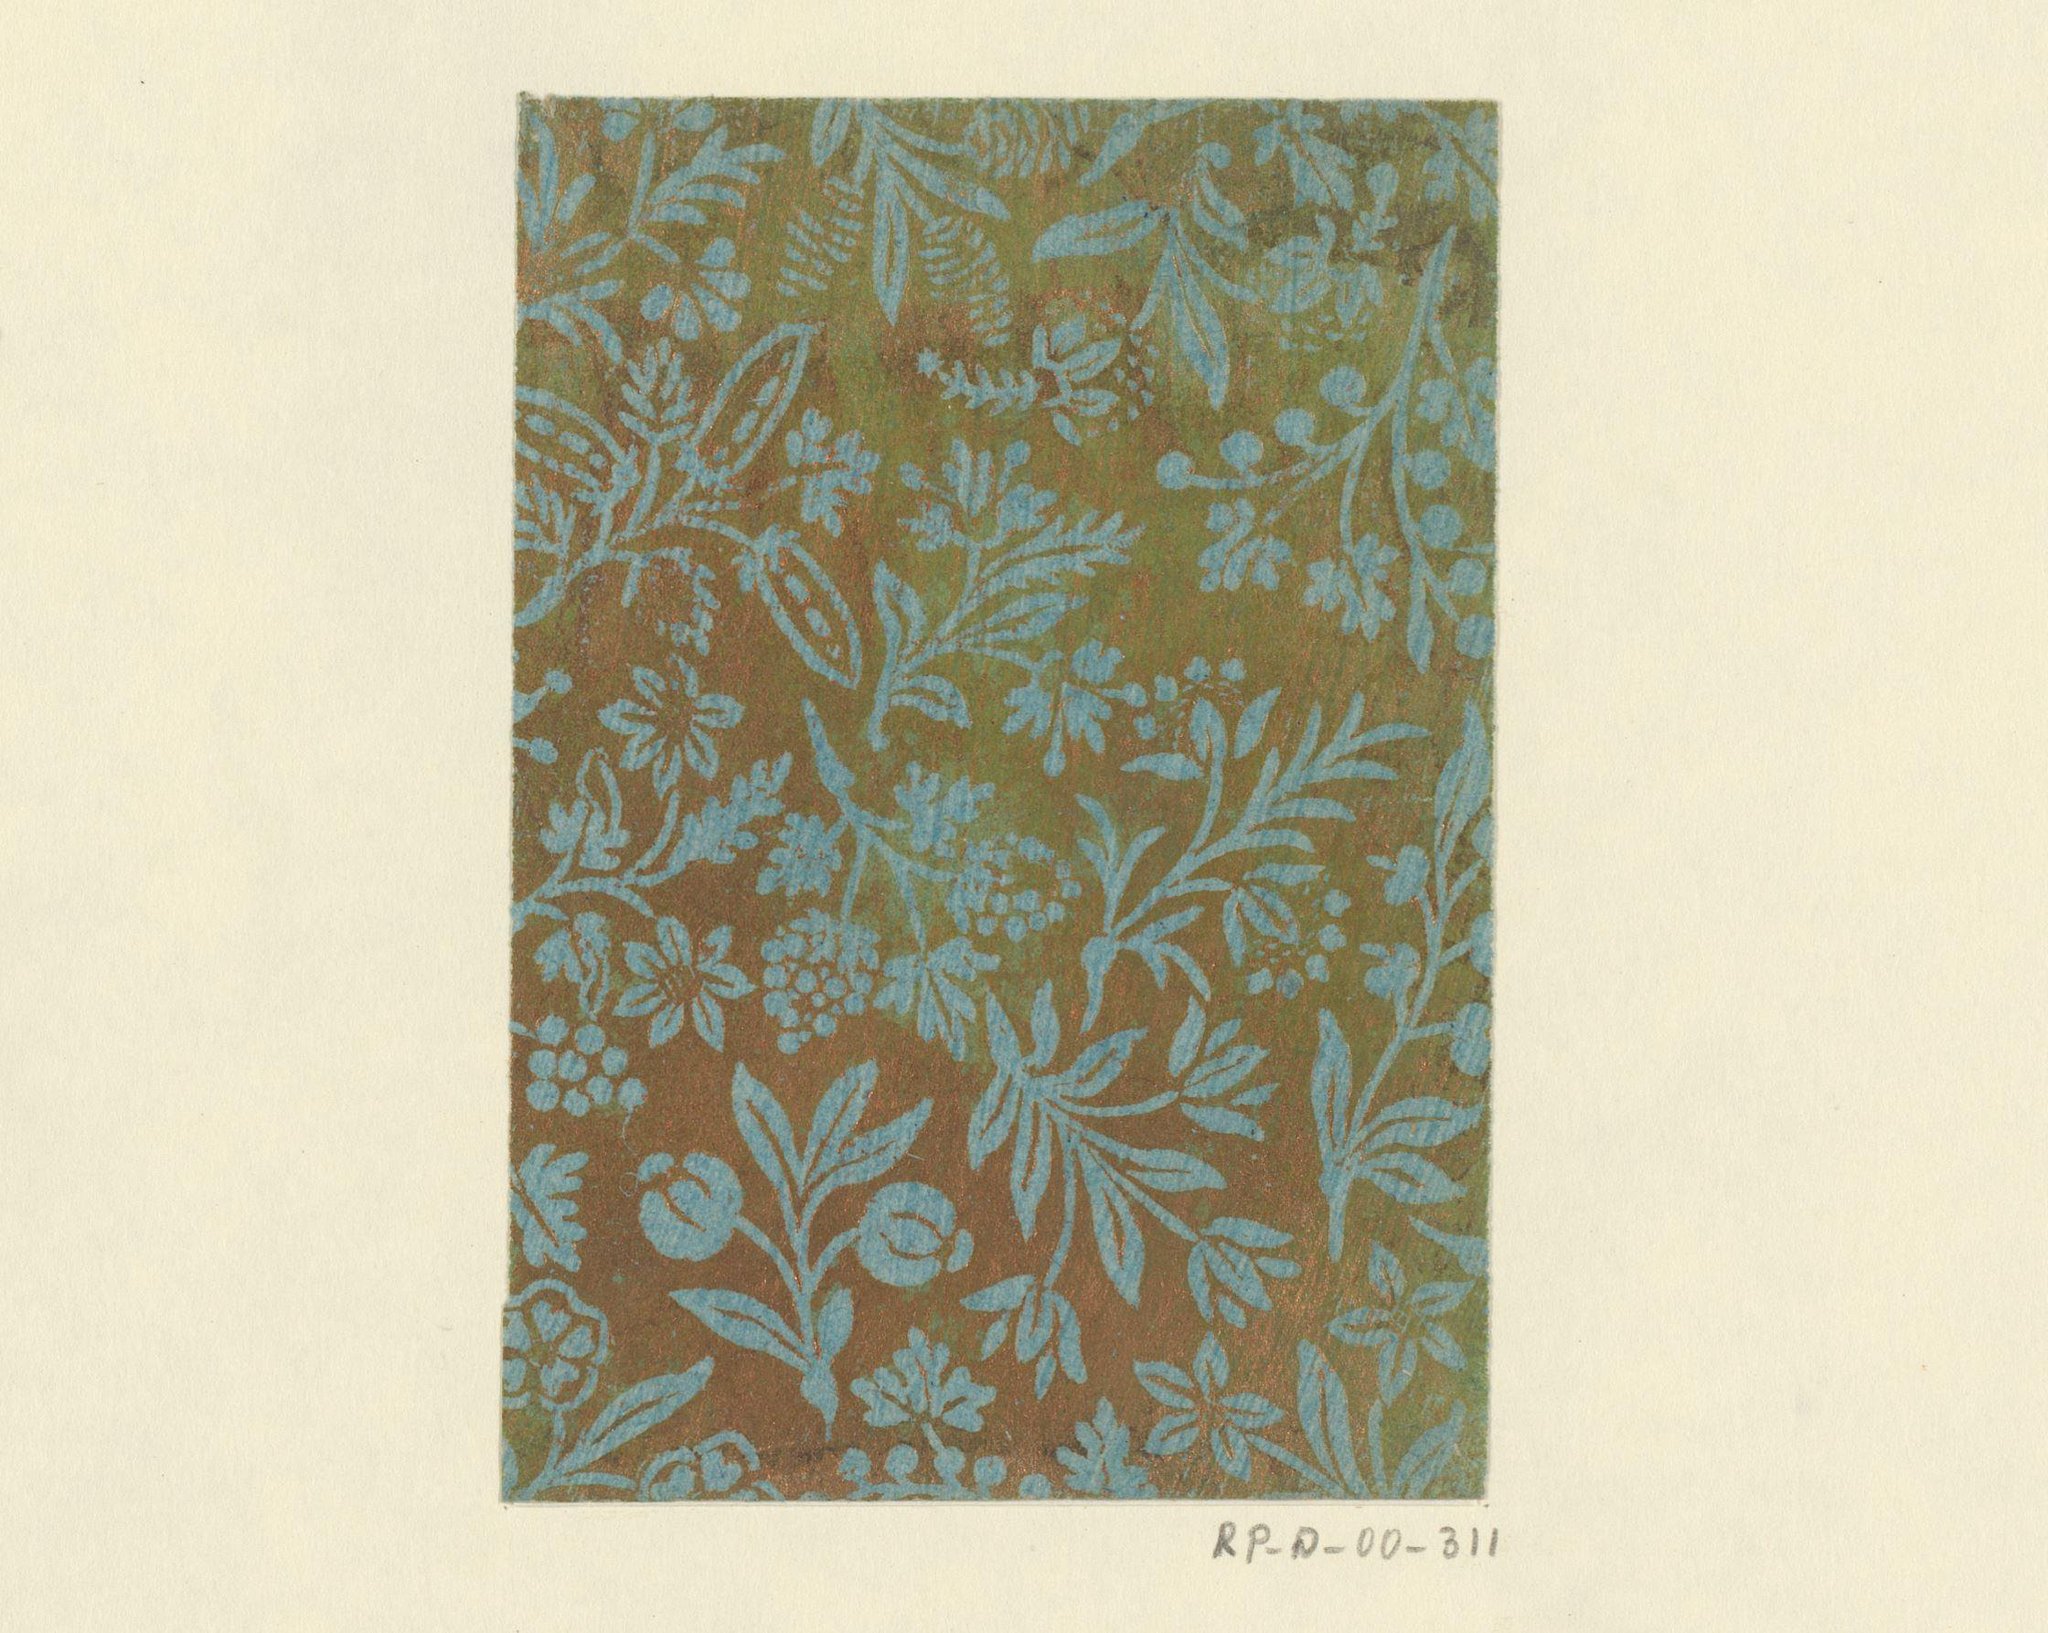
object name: brocade paper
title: Blad met bloemen en vruchten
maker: Anonymous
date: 1700-1800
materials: gold leaf, paint, paper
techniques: relief print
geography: germany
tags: ornament derived from plant forms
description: Blad met losse takken bloemen en vruchten (klein fragment).